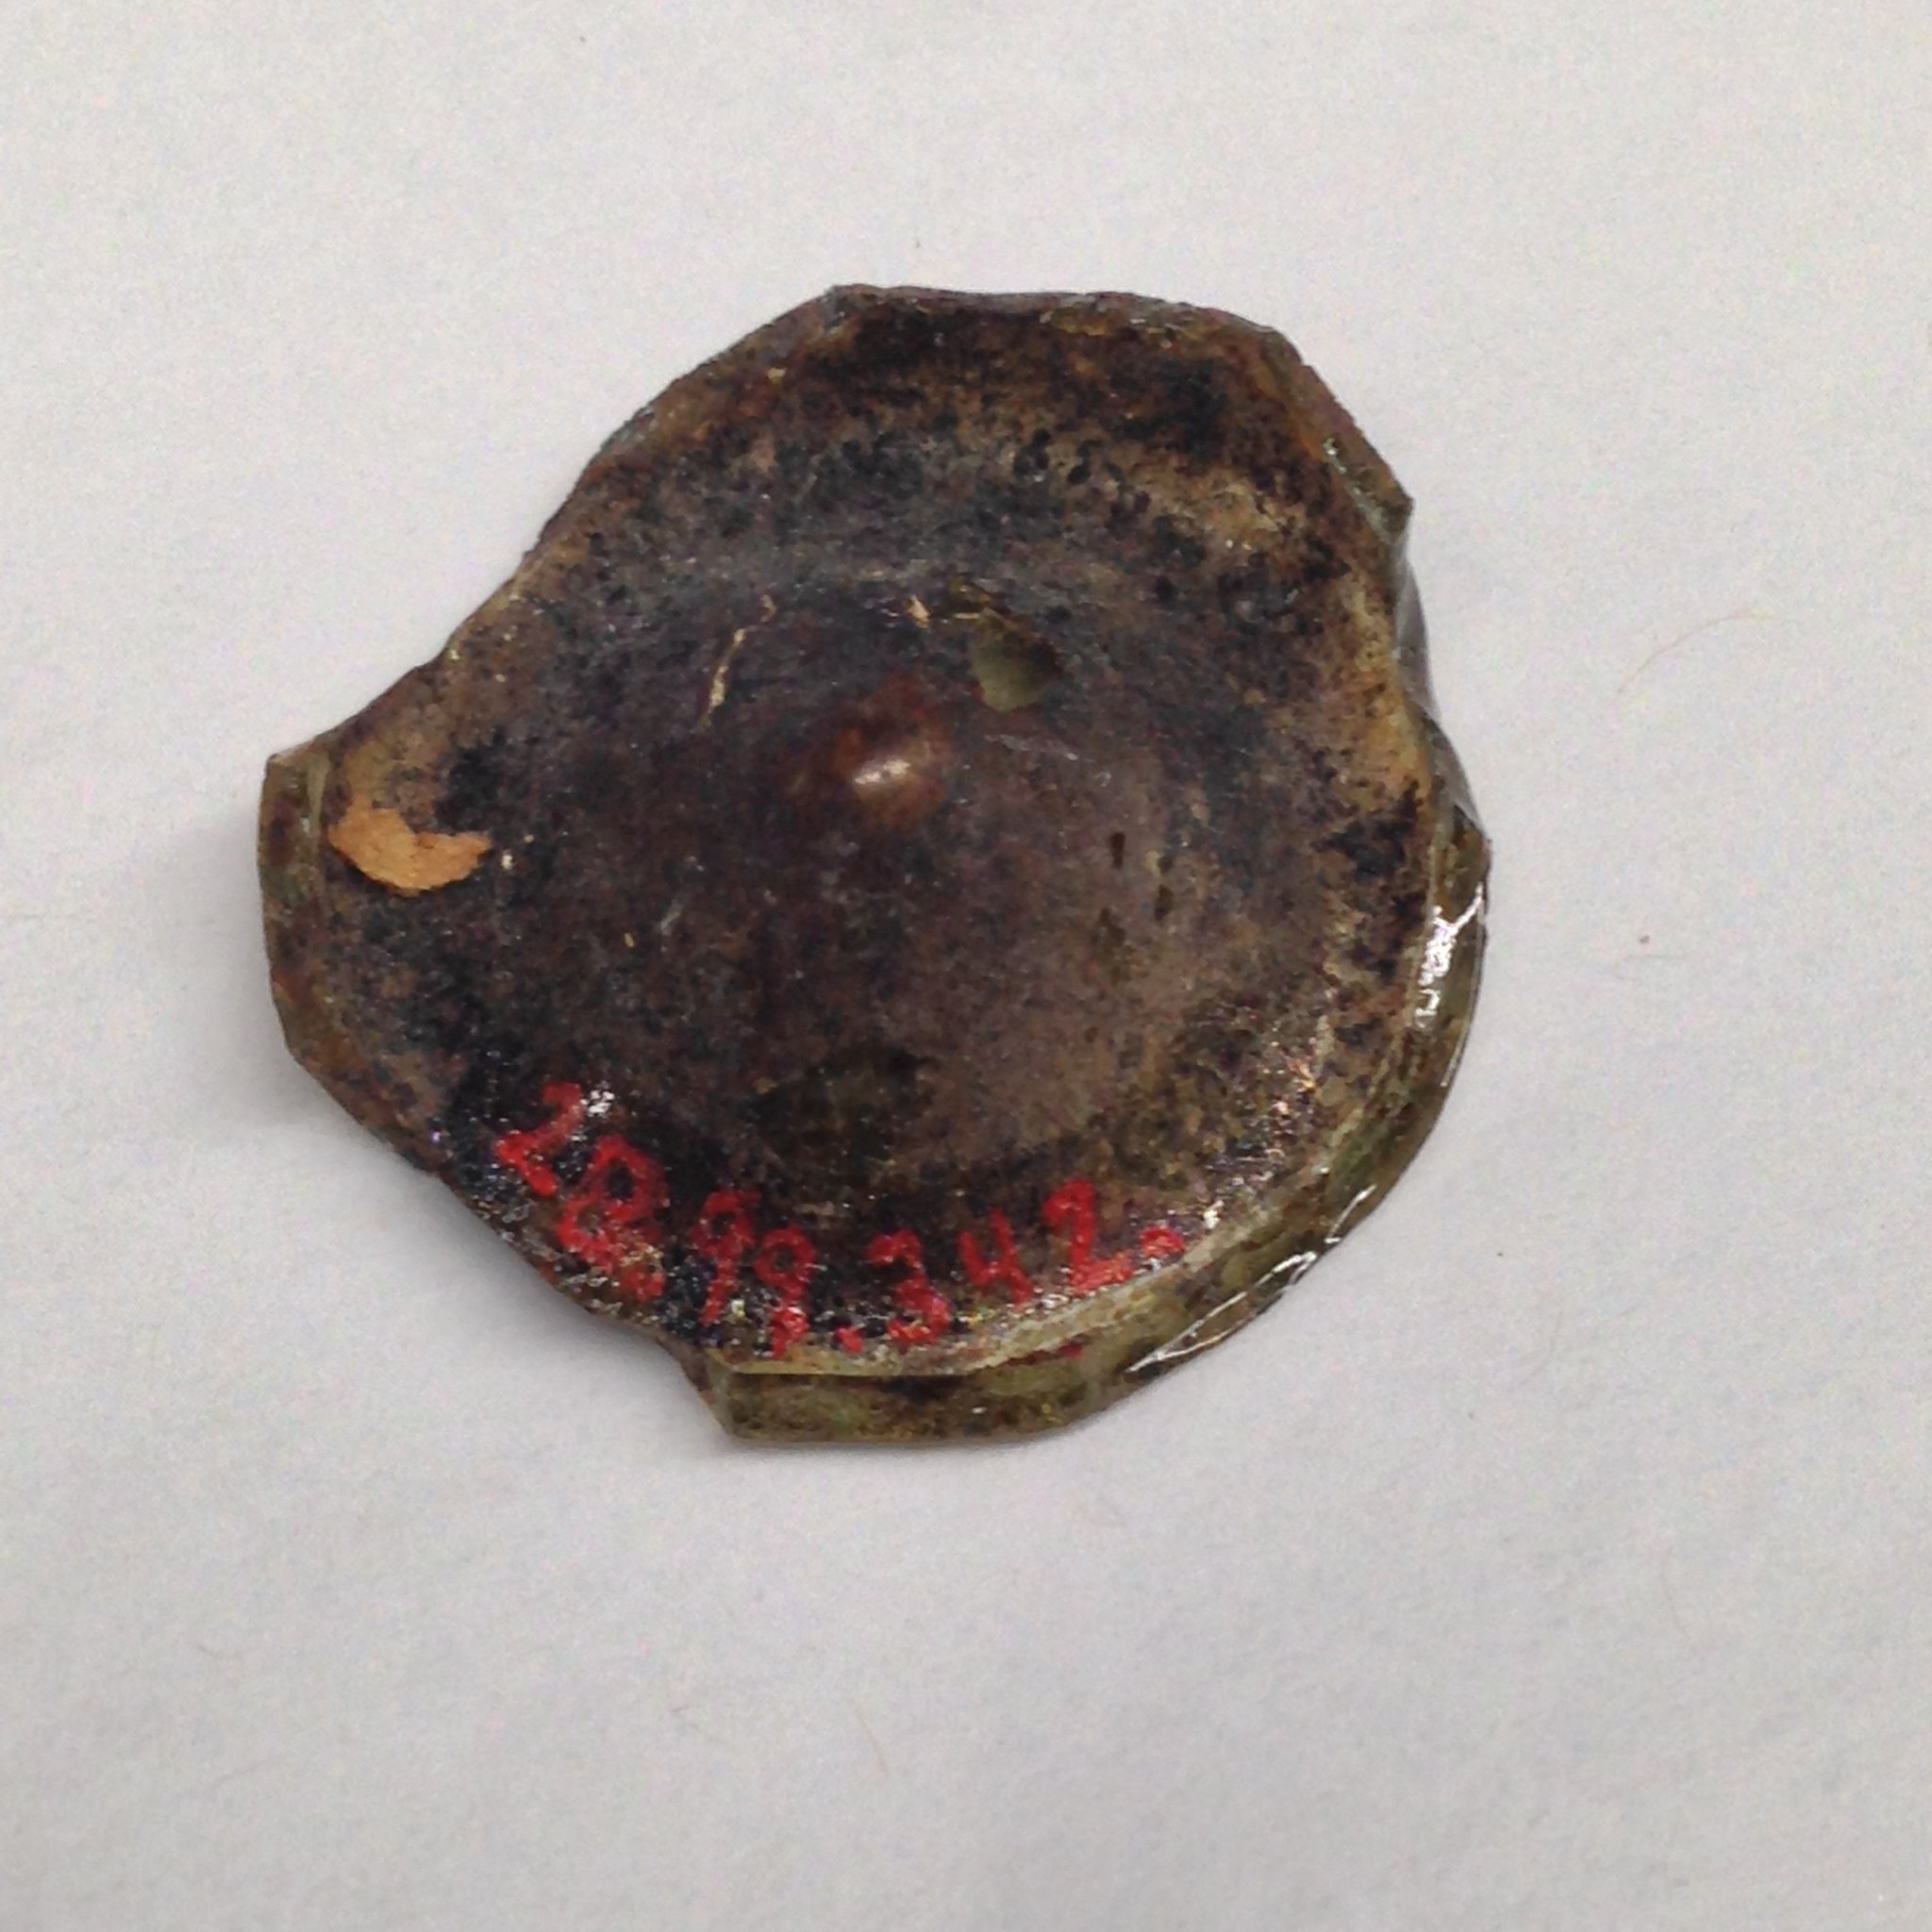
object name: fragment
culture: european or middle eastern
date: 1150-1250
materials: ceramic, glass